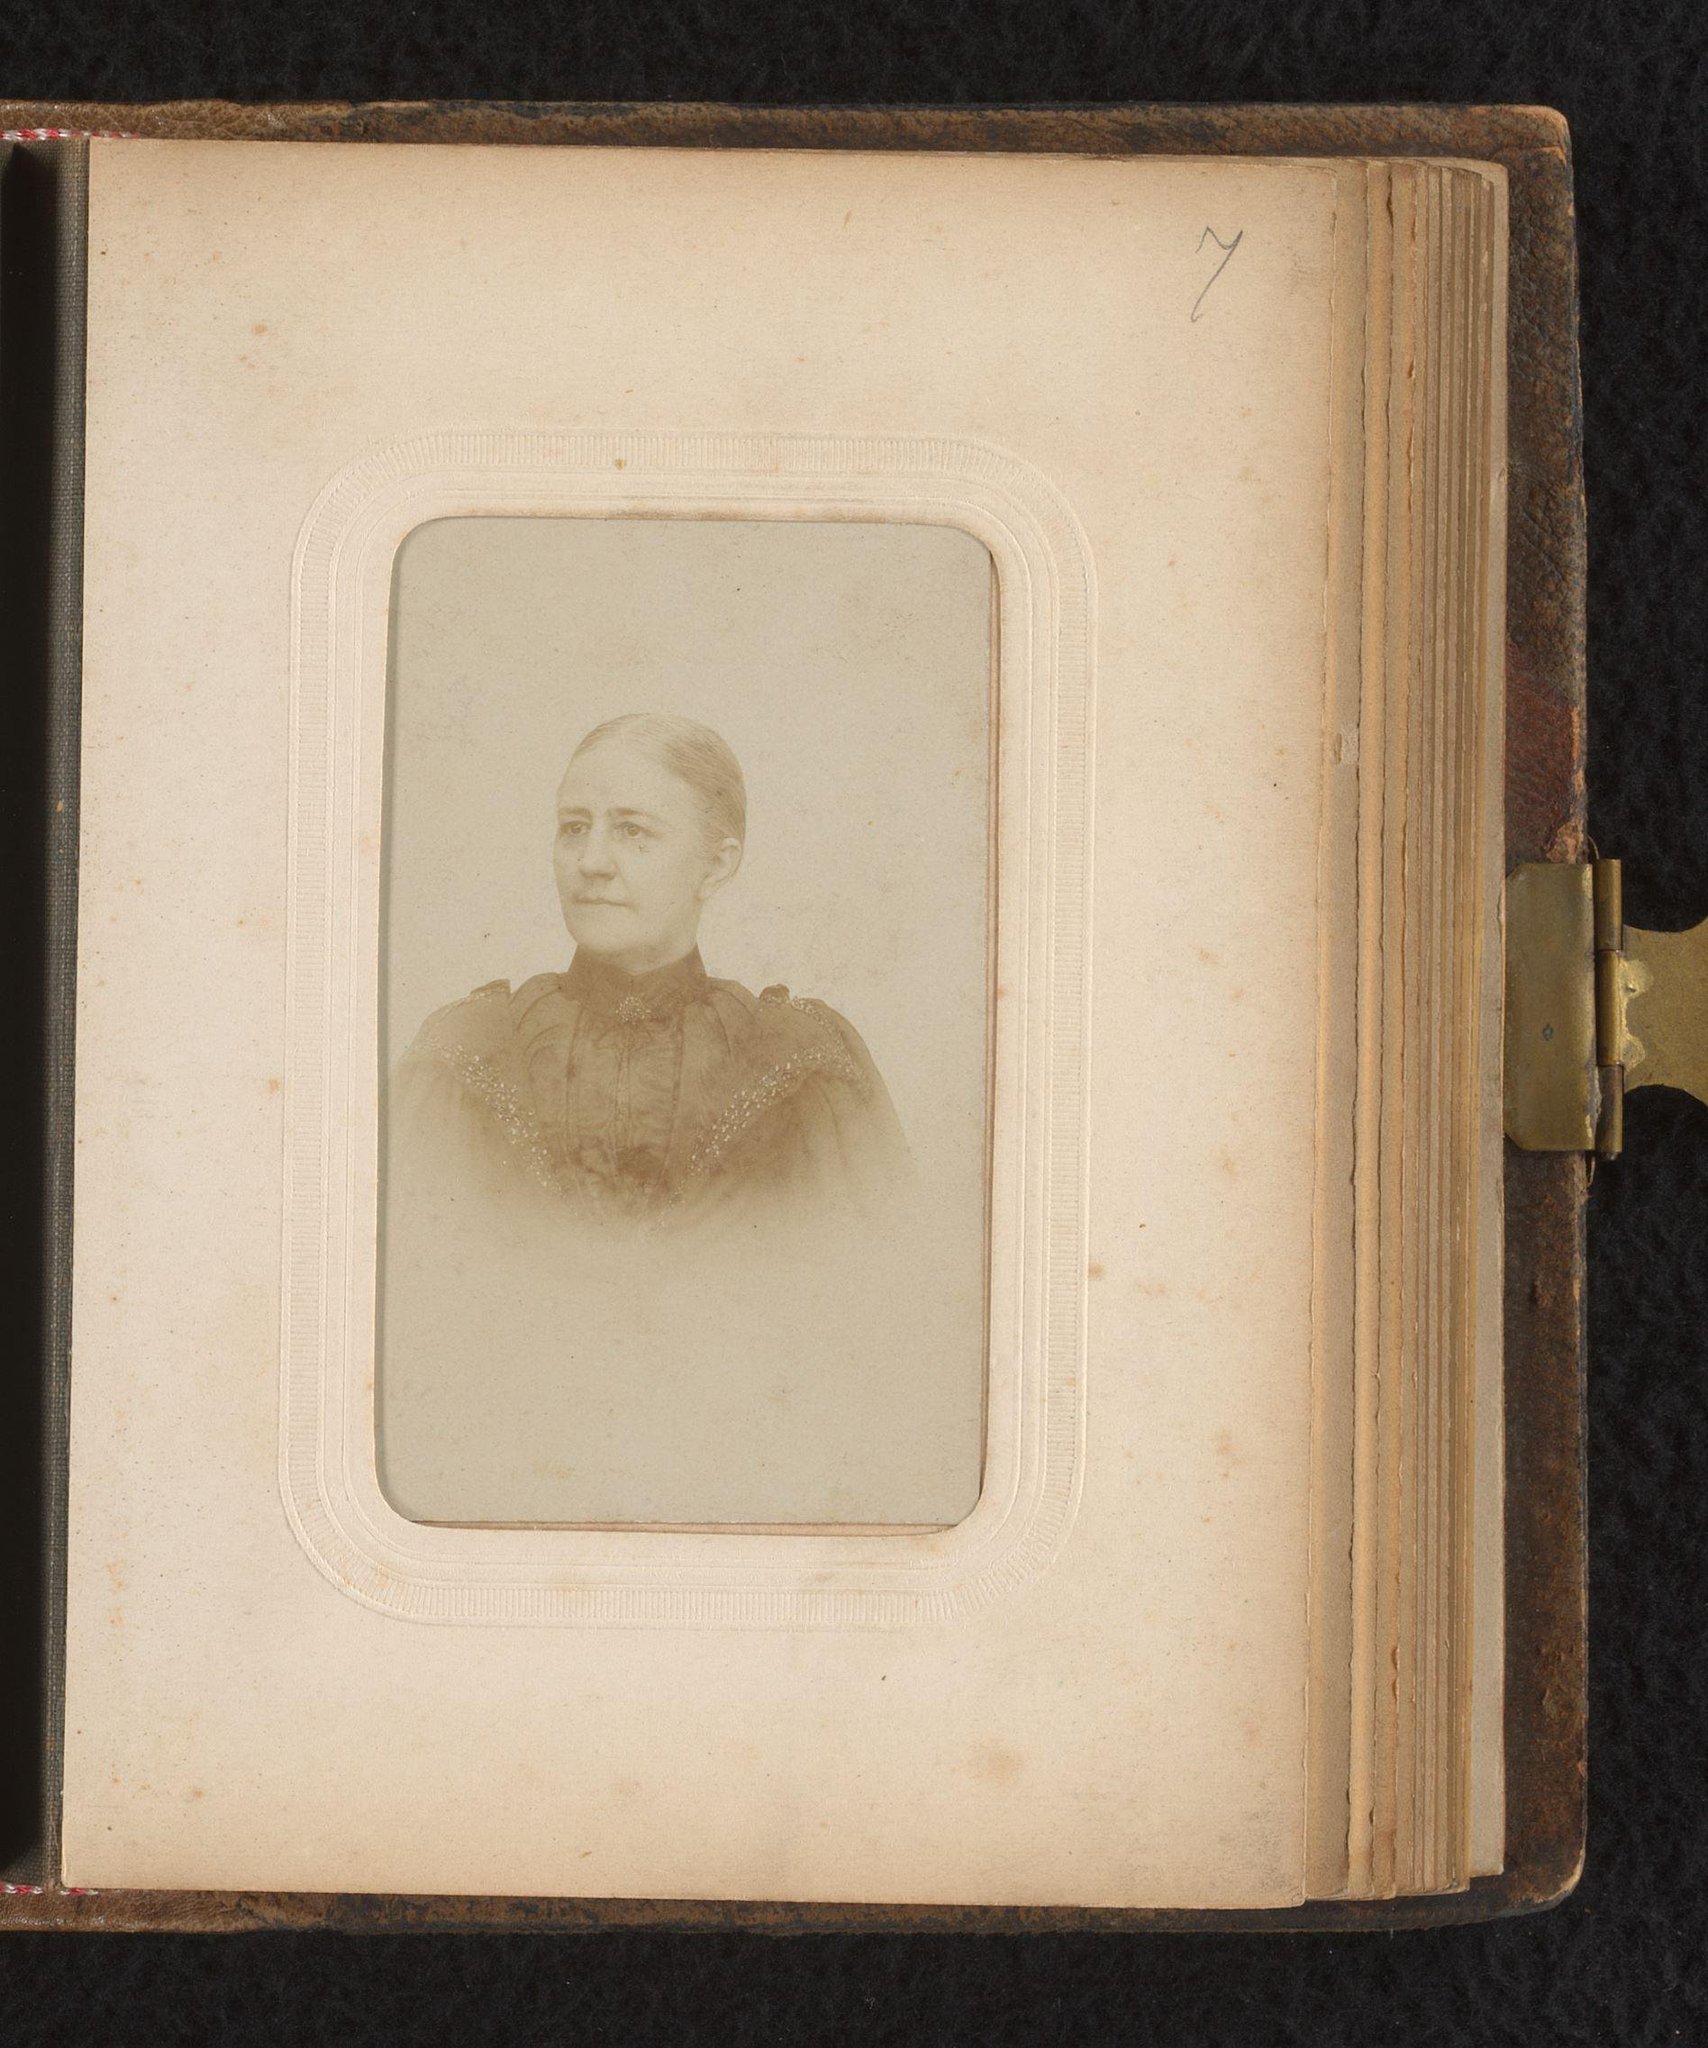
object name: photograph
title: Portret van Guurtje van Leijden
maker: coenraad jacob snooij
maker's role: publisher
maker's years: 1874-1972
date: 1895-1900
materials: paper, cardboard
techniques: collodion silver print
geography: north holland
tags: amsterdam, historical persons - bb - woman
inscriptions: inscription: ‘Guurtje van/ Leyden’, inscription: ‘Photographie C.J. Snooij’